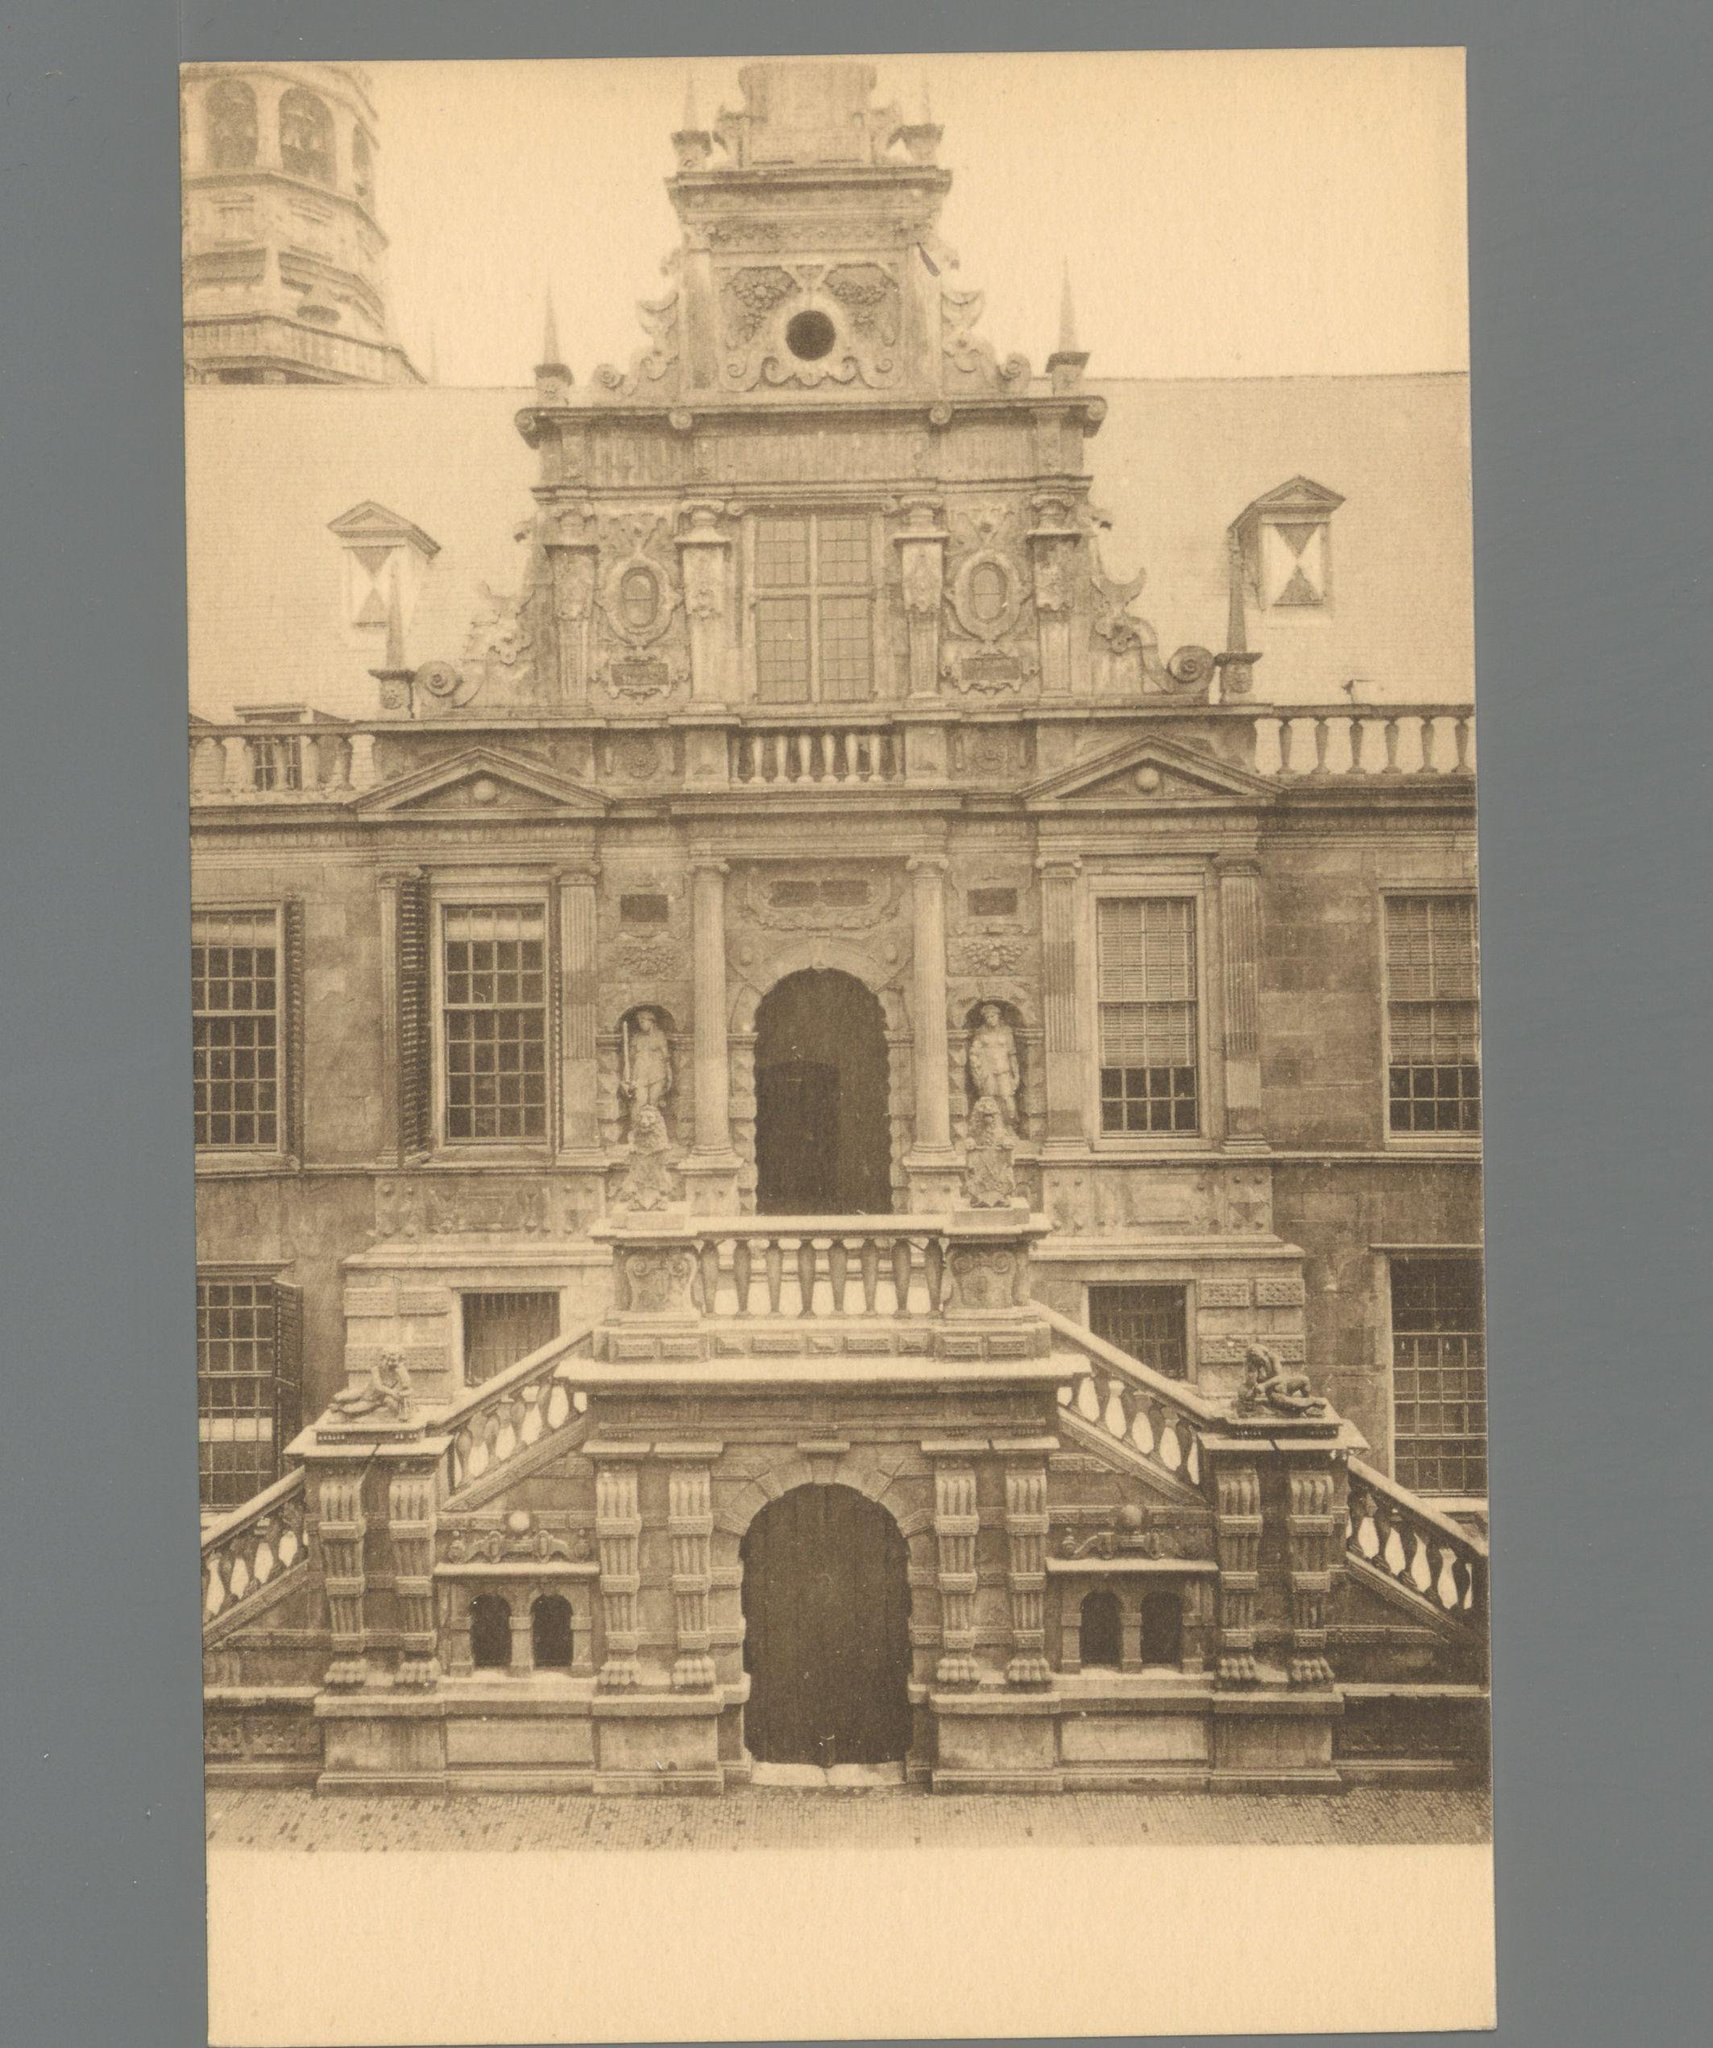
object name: photomechanical print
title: Leiden. Raadhuis, middenbouw met trap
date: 1905-1930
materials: cardboard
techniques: photograph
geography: leiden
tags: townhall